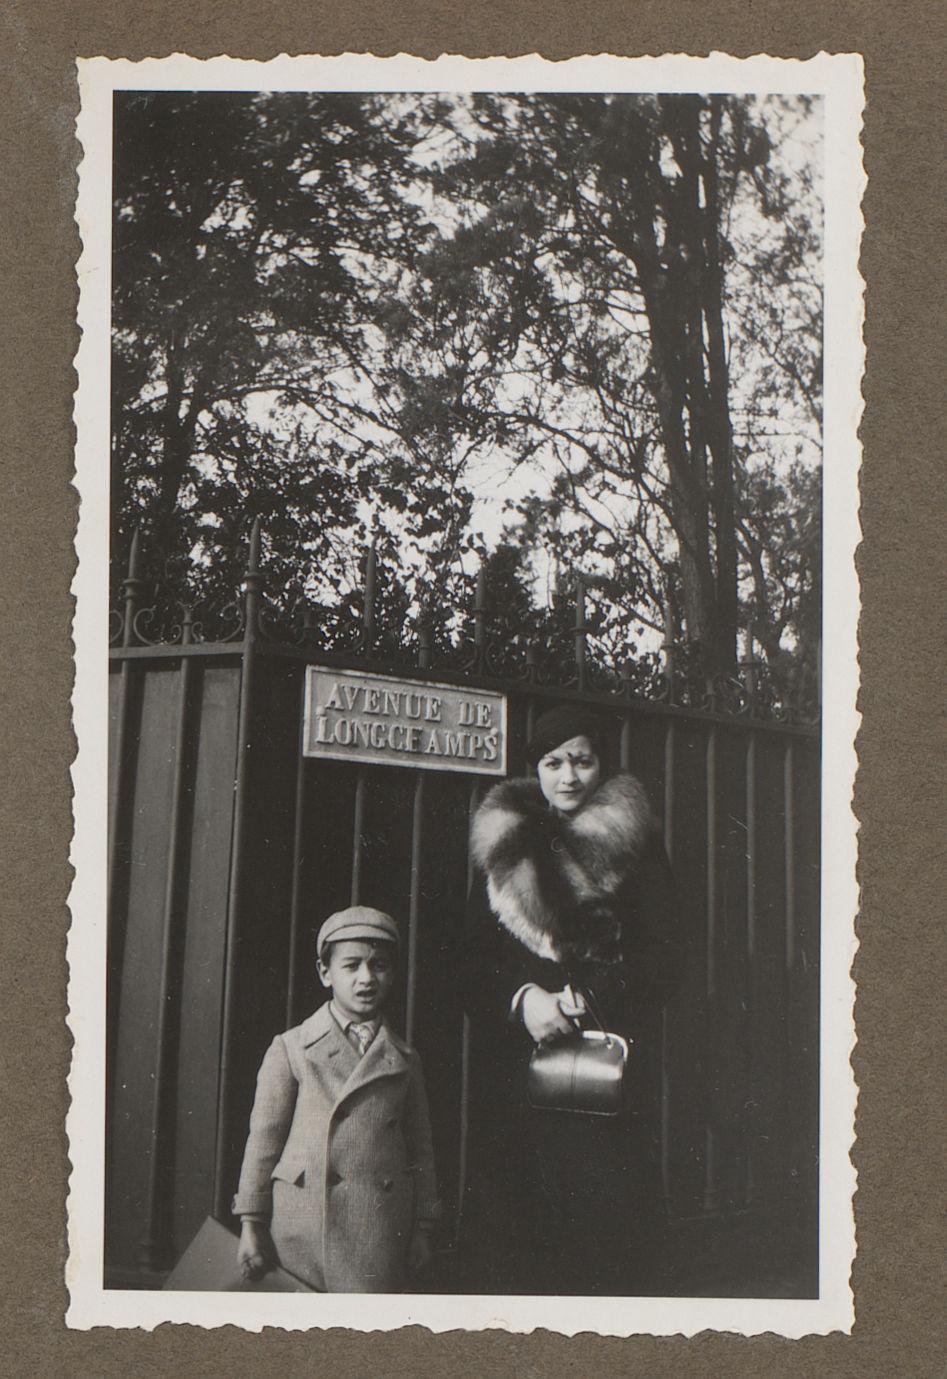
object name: photograph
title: Portret van Wilhelmina van Zijll de Jong en een kind op de Avenue de Longchamps, Parijs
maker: Anonymous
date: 1911-1933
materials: paper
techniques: gelatin silver print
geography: paris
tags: the hague, wilhelmina van zijll de jong, historical persons not known by name - bb - woman, historical persons not known by name, paris